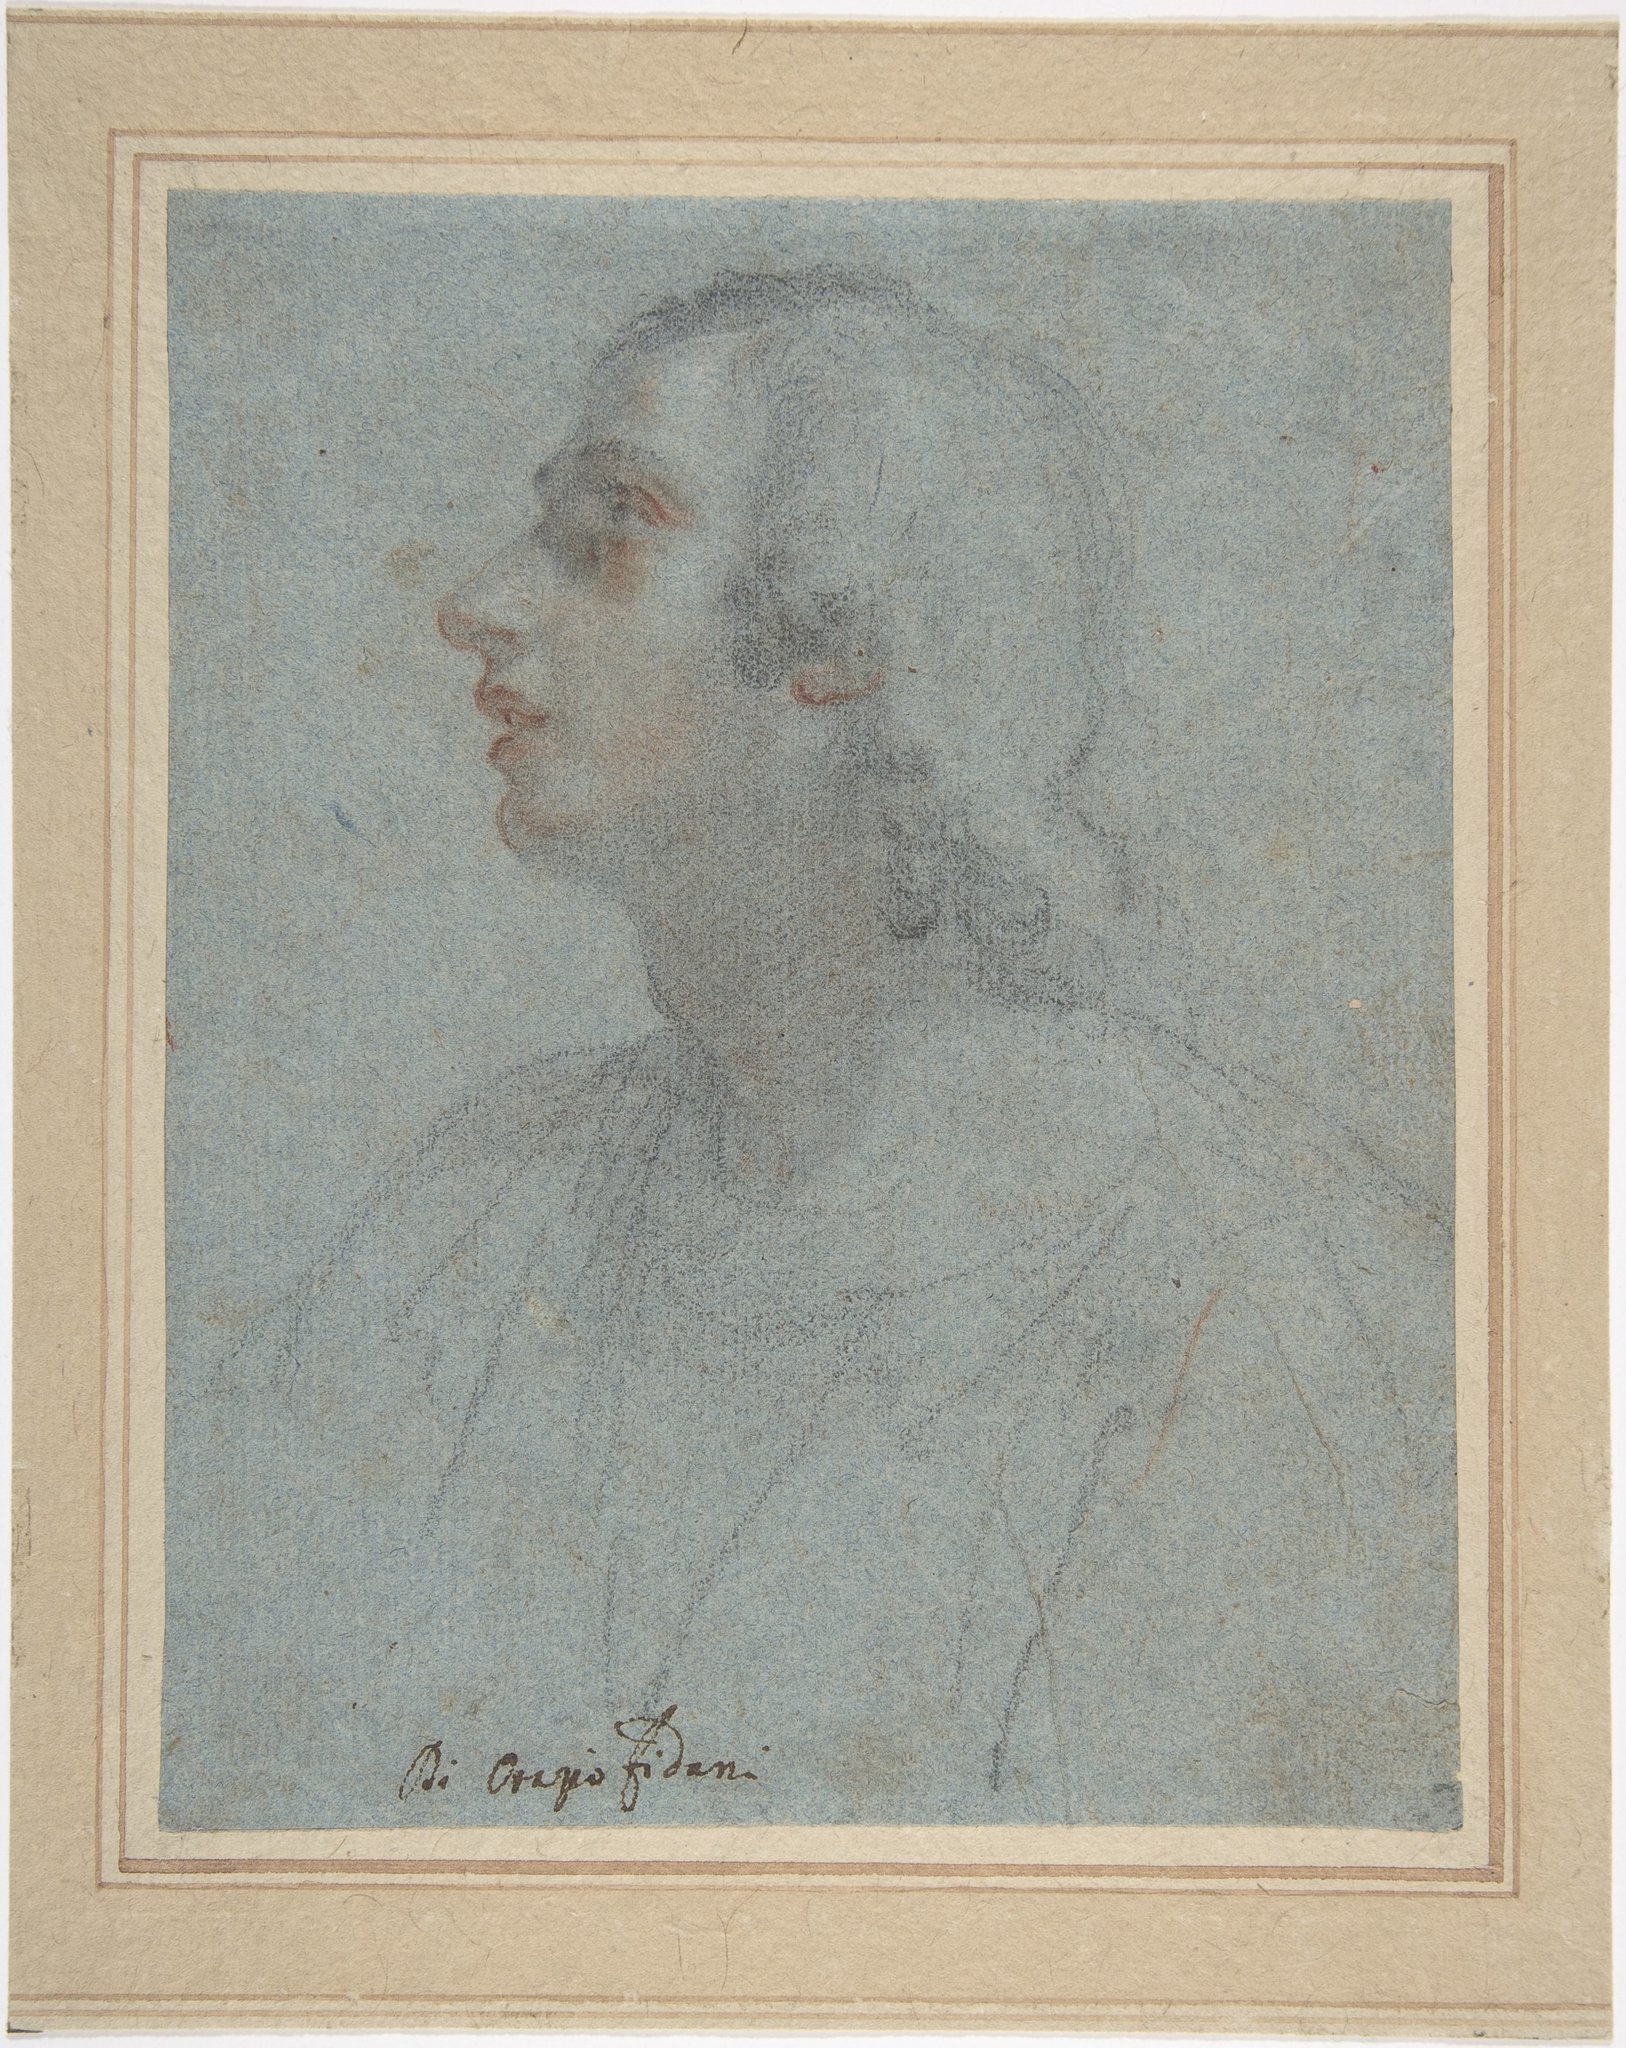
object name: drawing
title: Bust of a Youth Looking to Upper Left (recto); Study of Drapery (verso)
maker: orazio fidani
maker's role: artist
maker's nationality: italian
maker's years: 1606-1656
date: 1610-1656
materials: chalk, paper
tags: men,profiles